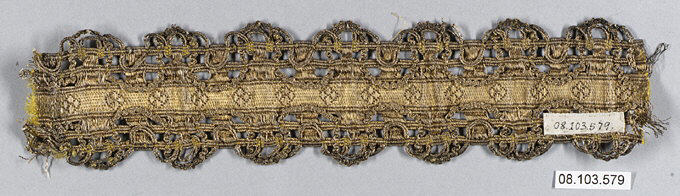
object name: galloon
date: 1601-1800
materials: metal thread